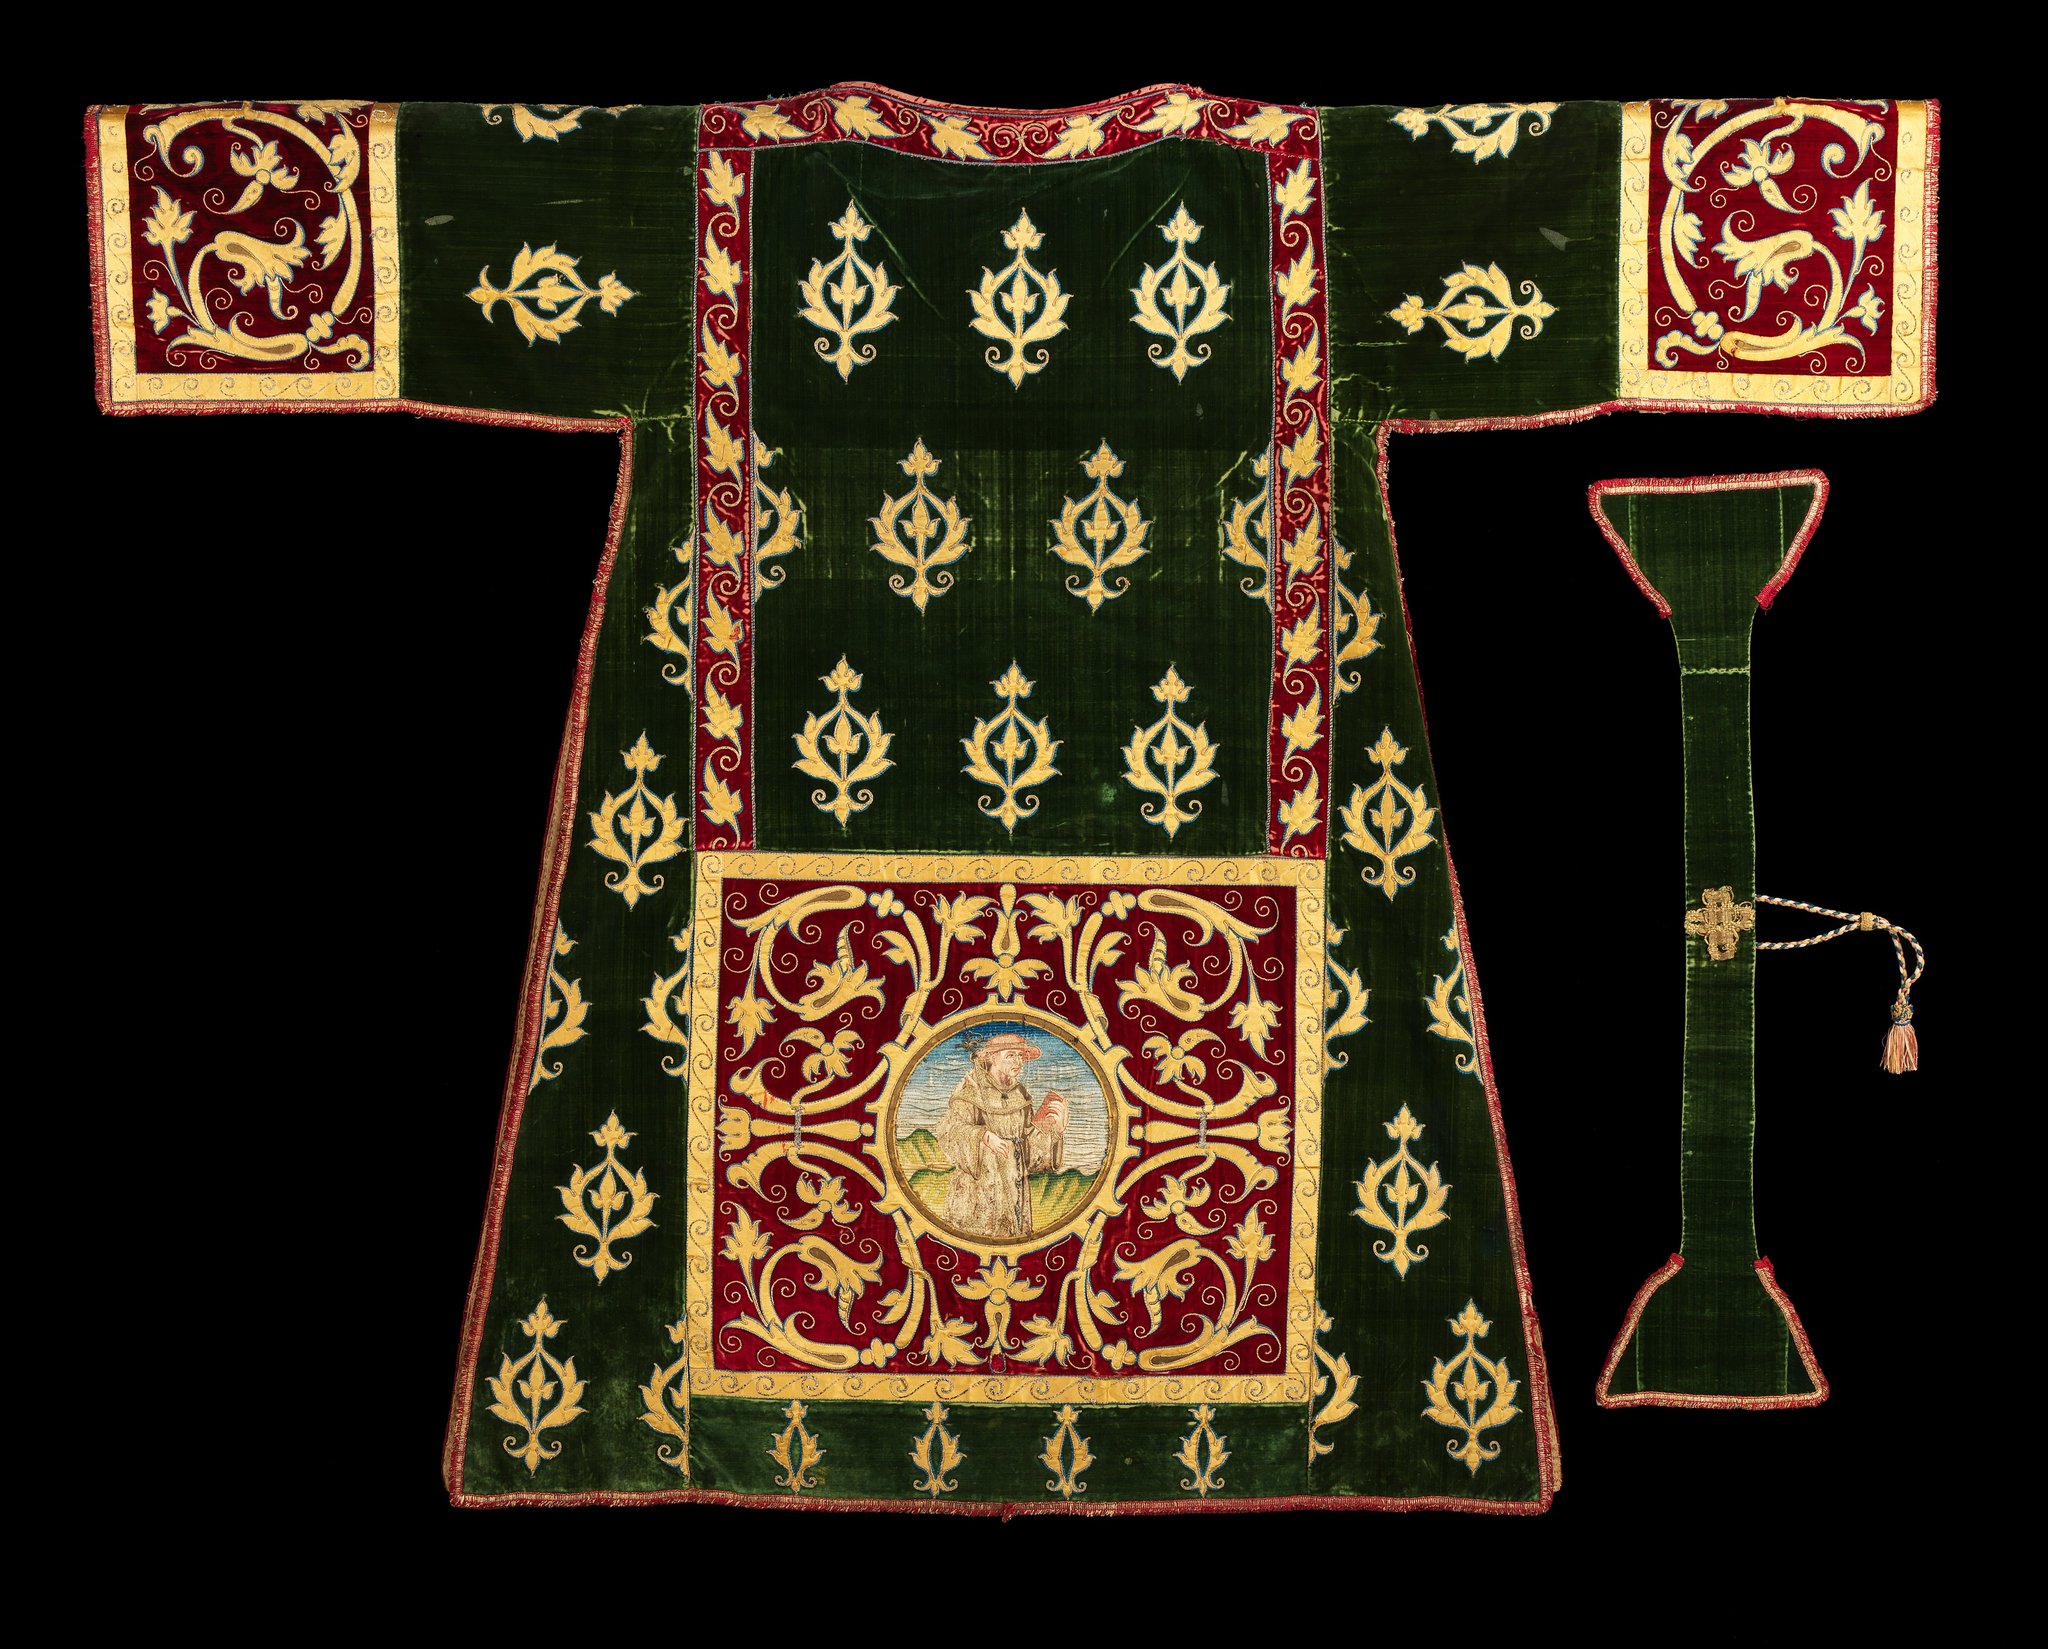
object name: vestment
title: Dalmatic and maniple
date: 1676-1700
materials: metal, silk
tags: saint john the baptist,saints